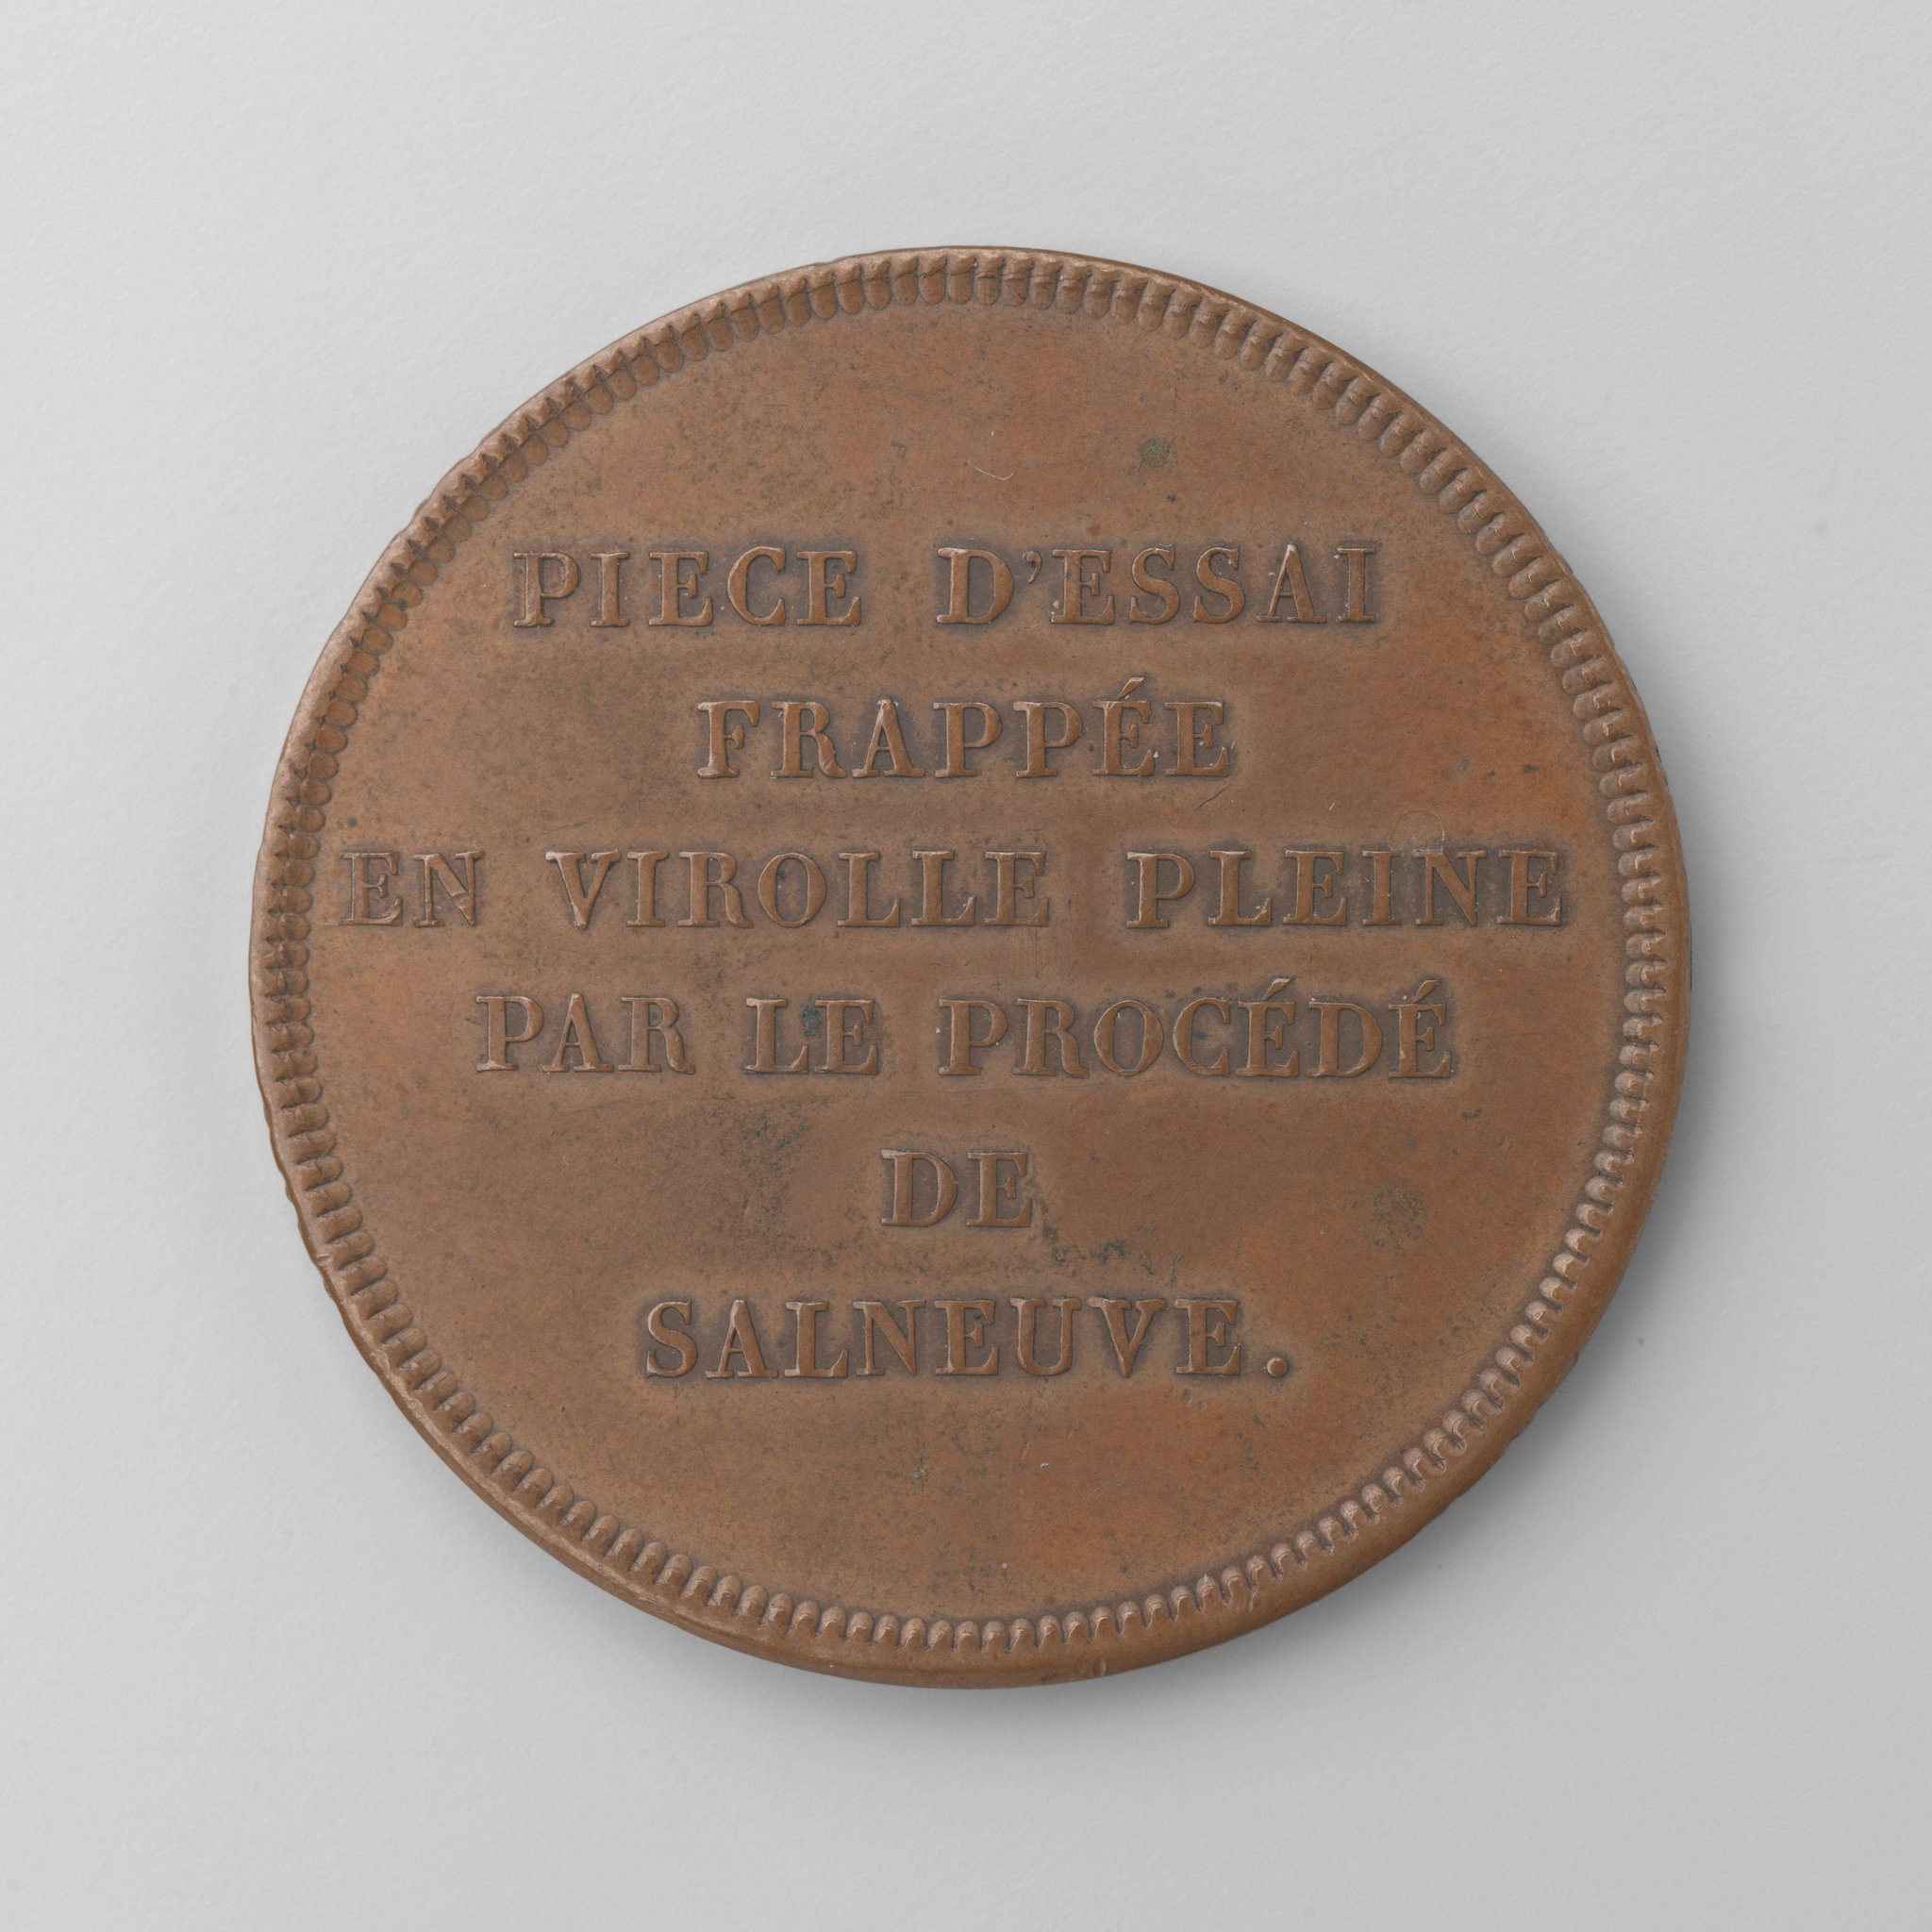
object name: coin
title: Rijksdaalder van het Koninkrijk Holland, 1808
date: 1808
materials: bronze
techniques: striking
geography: utrecht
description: Bronzen munt. Voorzijde: zes-regelig opschrift met naam Salneuve. Keerzijde: zes-regelig opschrift, waaronder jaartal. Randschrift. Proefslag in brons ter grootte van rijksdaalder met randschrift volgens het systeem van Salneuve.